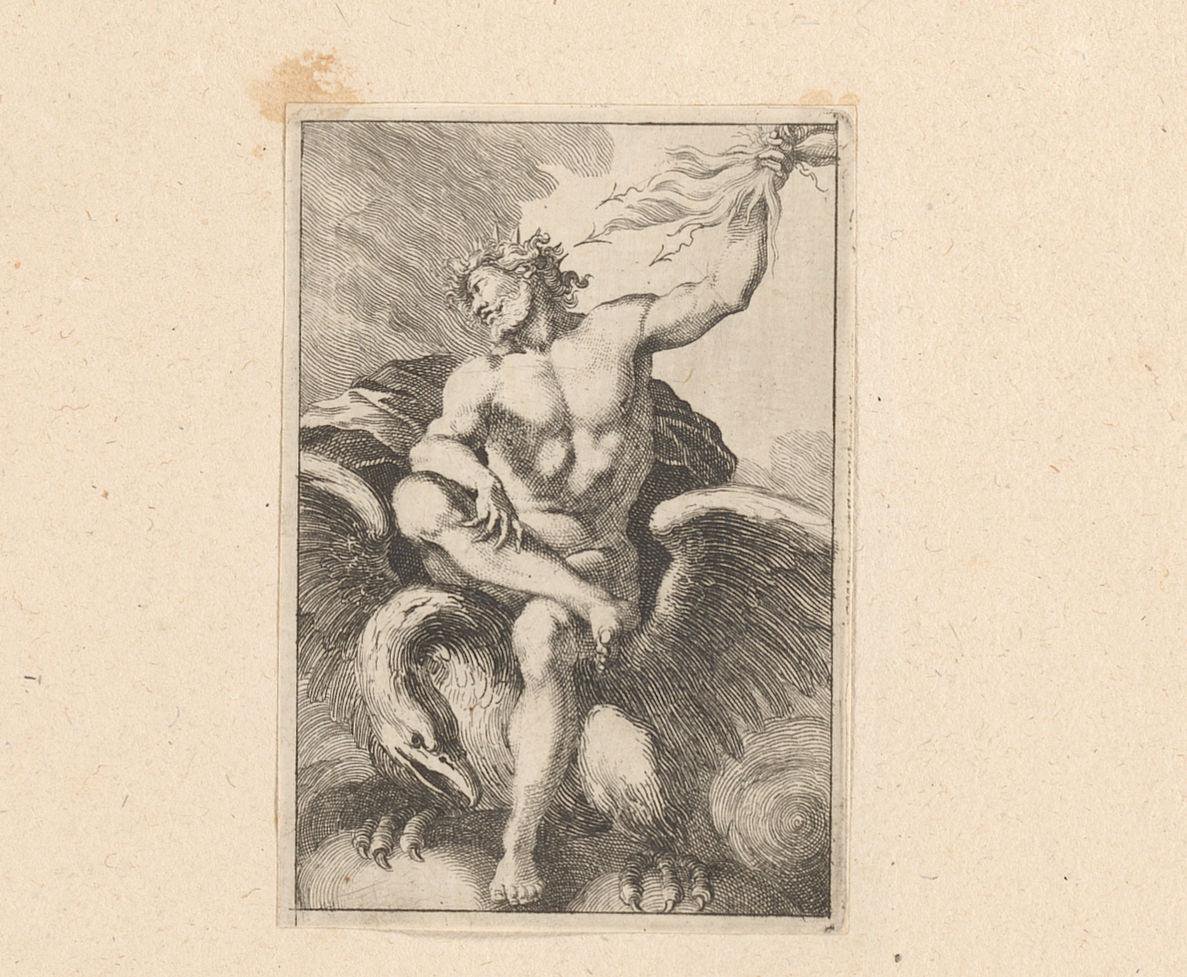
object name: album leaf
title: Figures d'Academie pour apprendre à désiner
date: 1665-1673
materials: paper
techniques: etching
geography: paris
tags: model-books ~ implements of painter, (story of) jupiter (zeus)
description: Maakt deel uit van een 32-delige serie met tekenvoorbeelden van goden en helden uit de klassieke oudheid. Een eerste editie werd in 1673 uitgegeven en een tweede in 1684 door Nicolas Langlois.